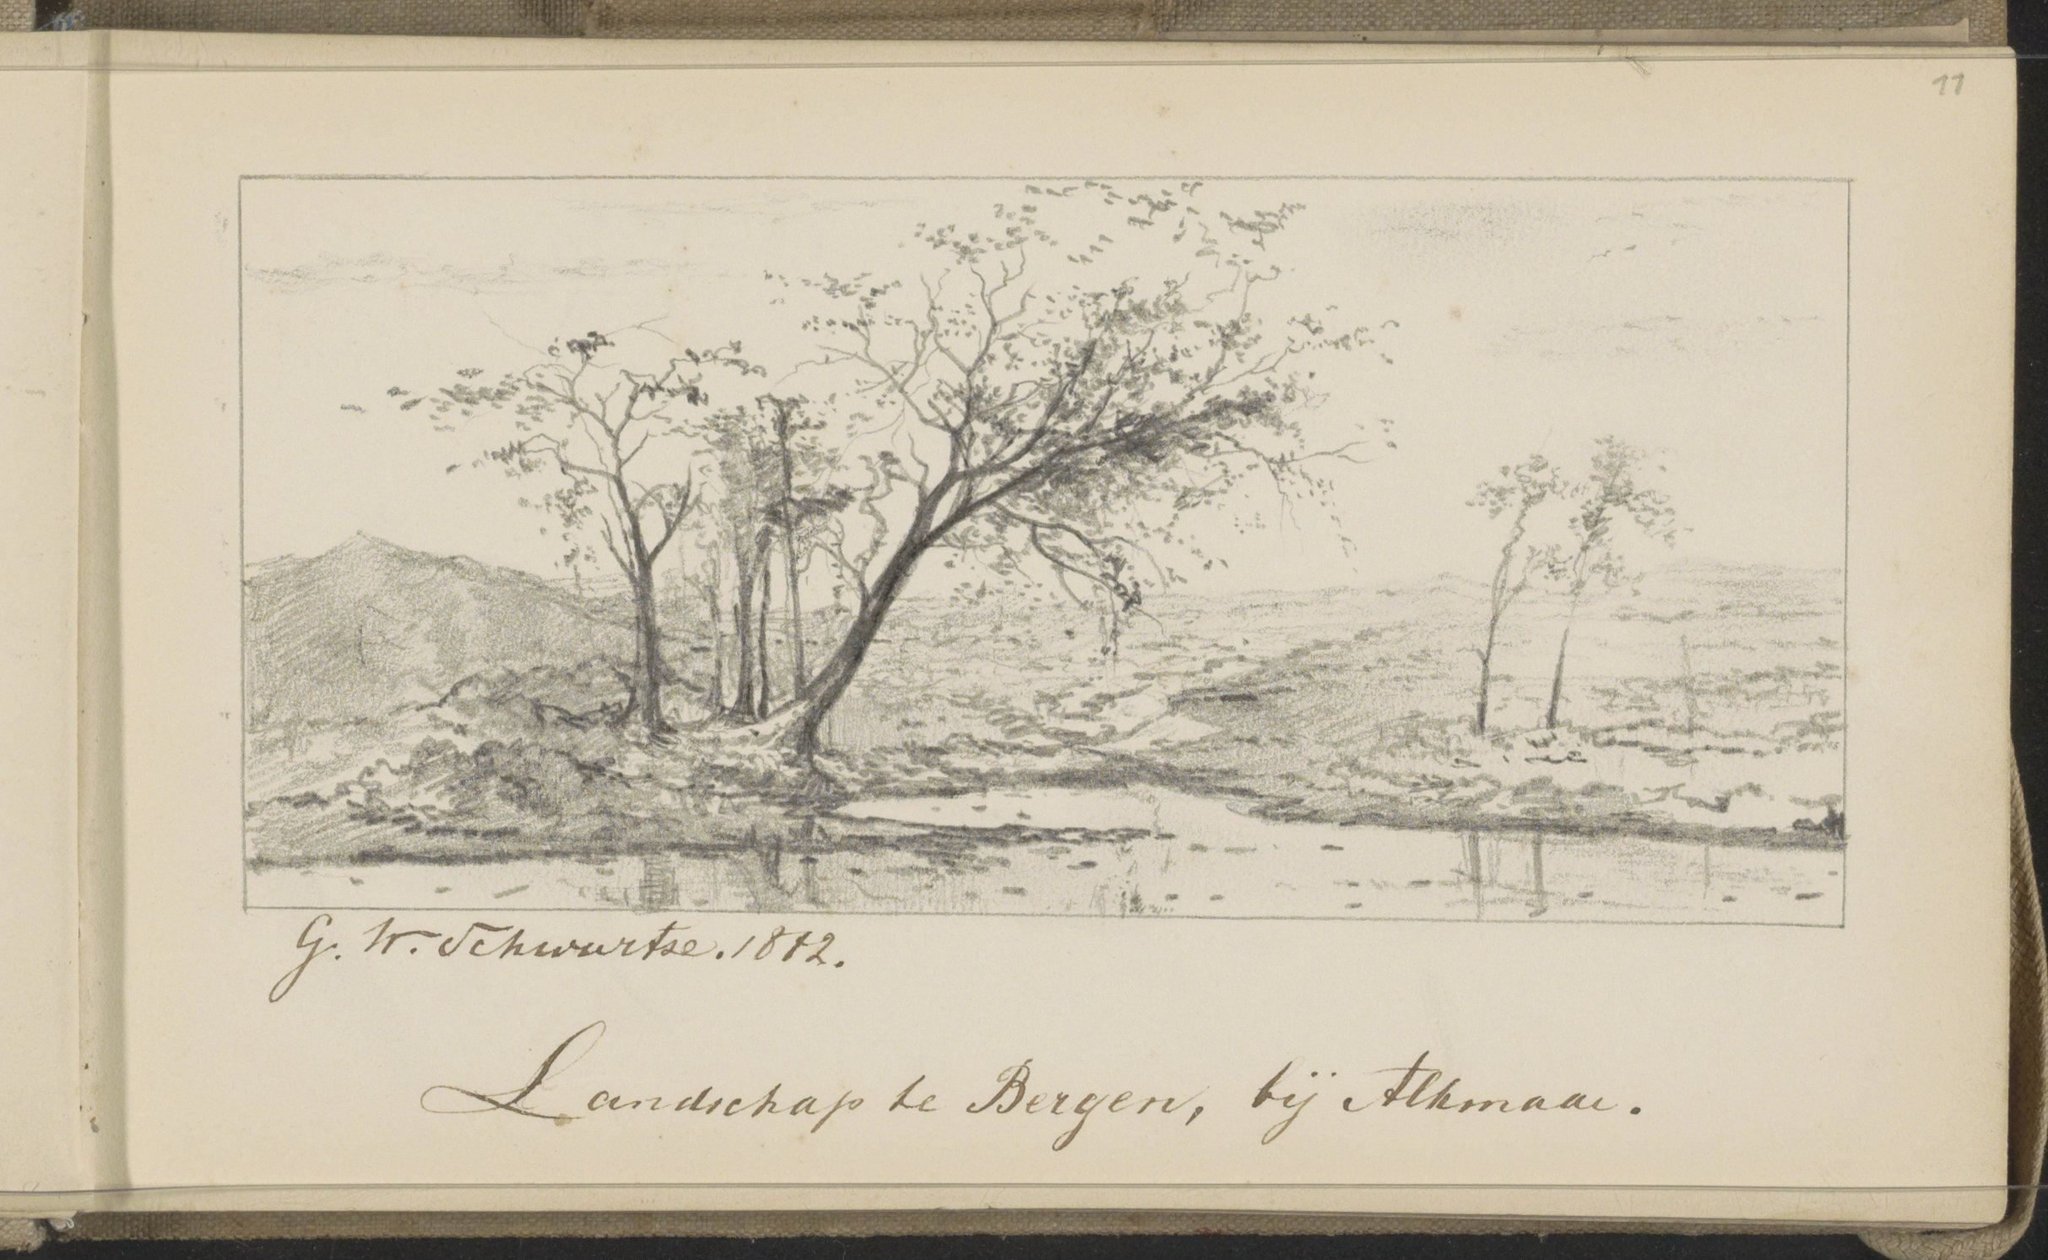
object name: sketchbook leaf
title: Landschap te Bergen, bij Alkmaar.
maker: george washington schwartze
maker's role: draughtsman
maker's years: 1857-1909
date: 1882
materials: paper, pencil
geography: bergen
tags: low hill country, landscapes with waters, waterscapes, seascapes (in the temperate zone)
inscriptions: title: ‘Landschap te Bergen, bij Alkmaar.’, signature and date: ‘G.W.Schwartze. 1882.’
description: Overhangende boom aan een waterkant met op de achtergrond een heuvelachtig landschap. Tekening in een kader. Blad 11 recto uit een schetsboek met 54 bladen.